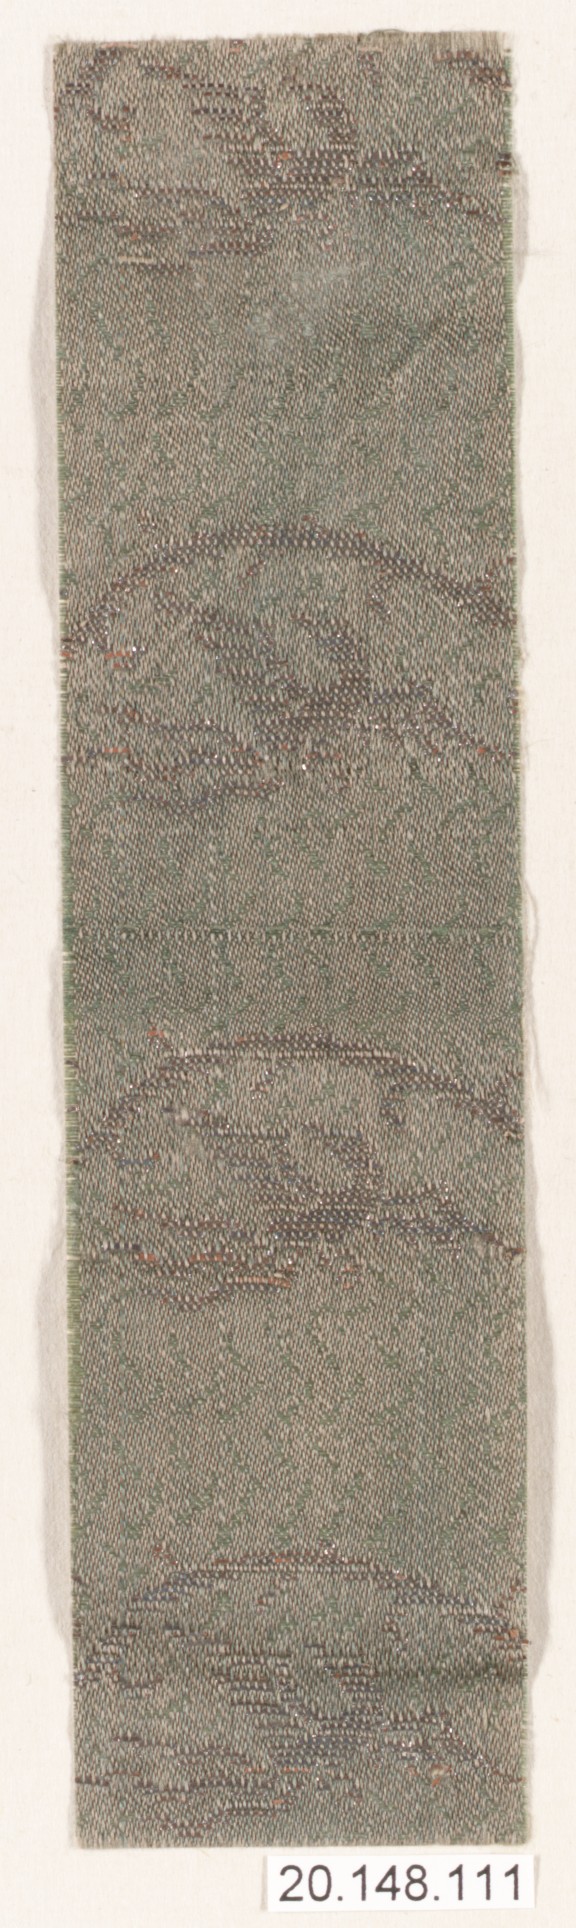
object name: piece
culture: japanese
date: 1701-1800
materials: silk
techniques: compound weave